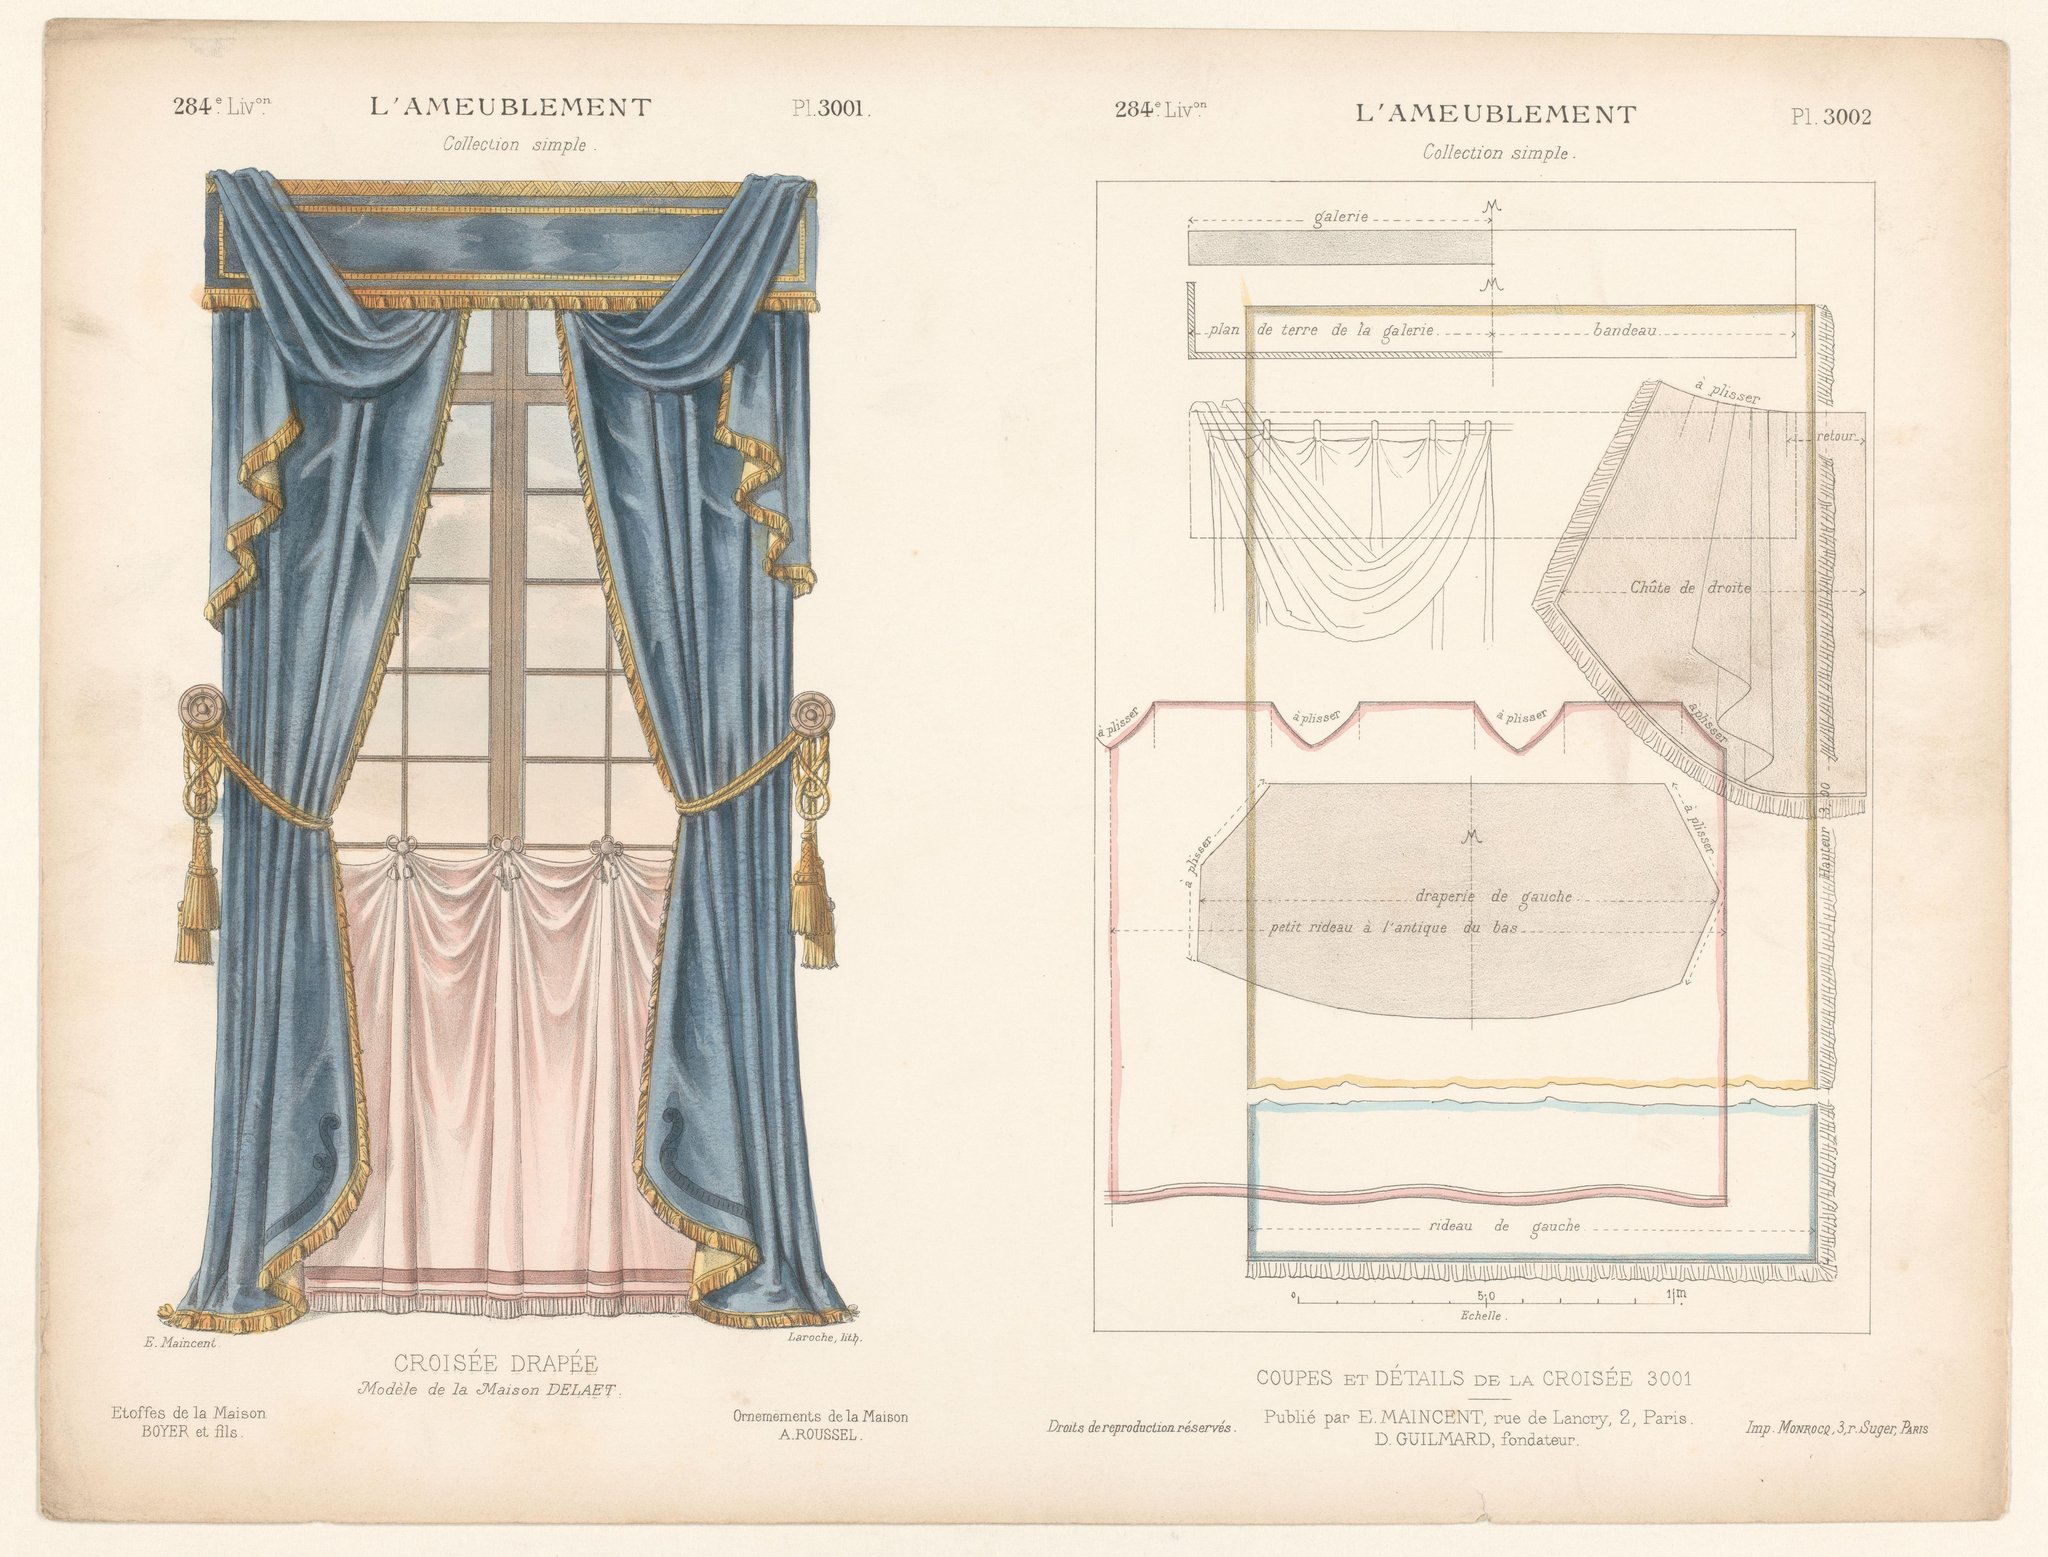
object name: print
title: Croisée drapée / Coupes et détails de la croisée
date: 1885-1895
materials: paper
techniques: hand coloring, lithograph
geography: paris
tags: window, hangings and drapery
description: Een venster met gedrapeerde gordijnen. Rechts details van de draperieën. Prent uit 284e Livraison.